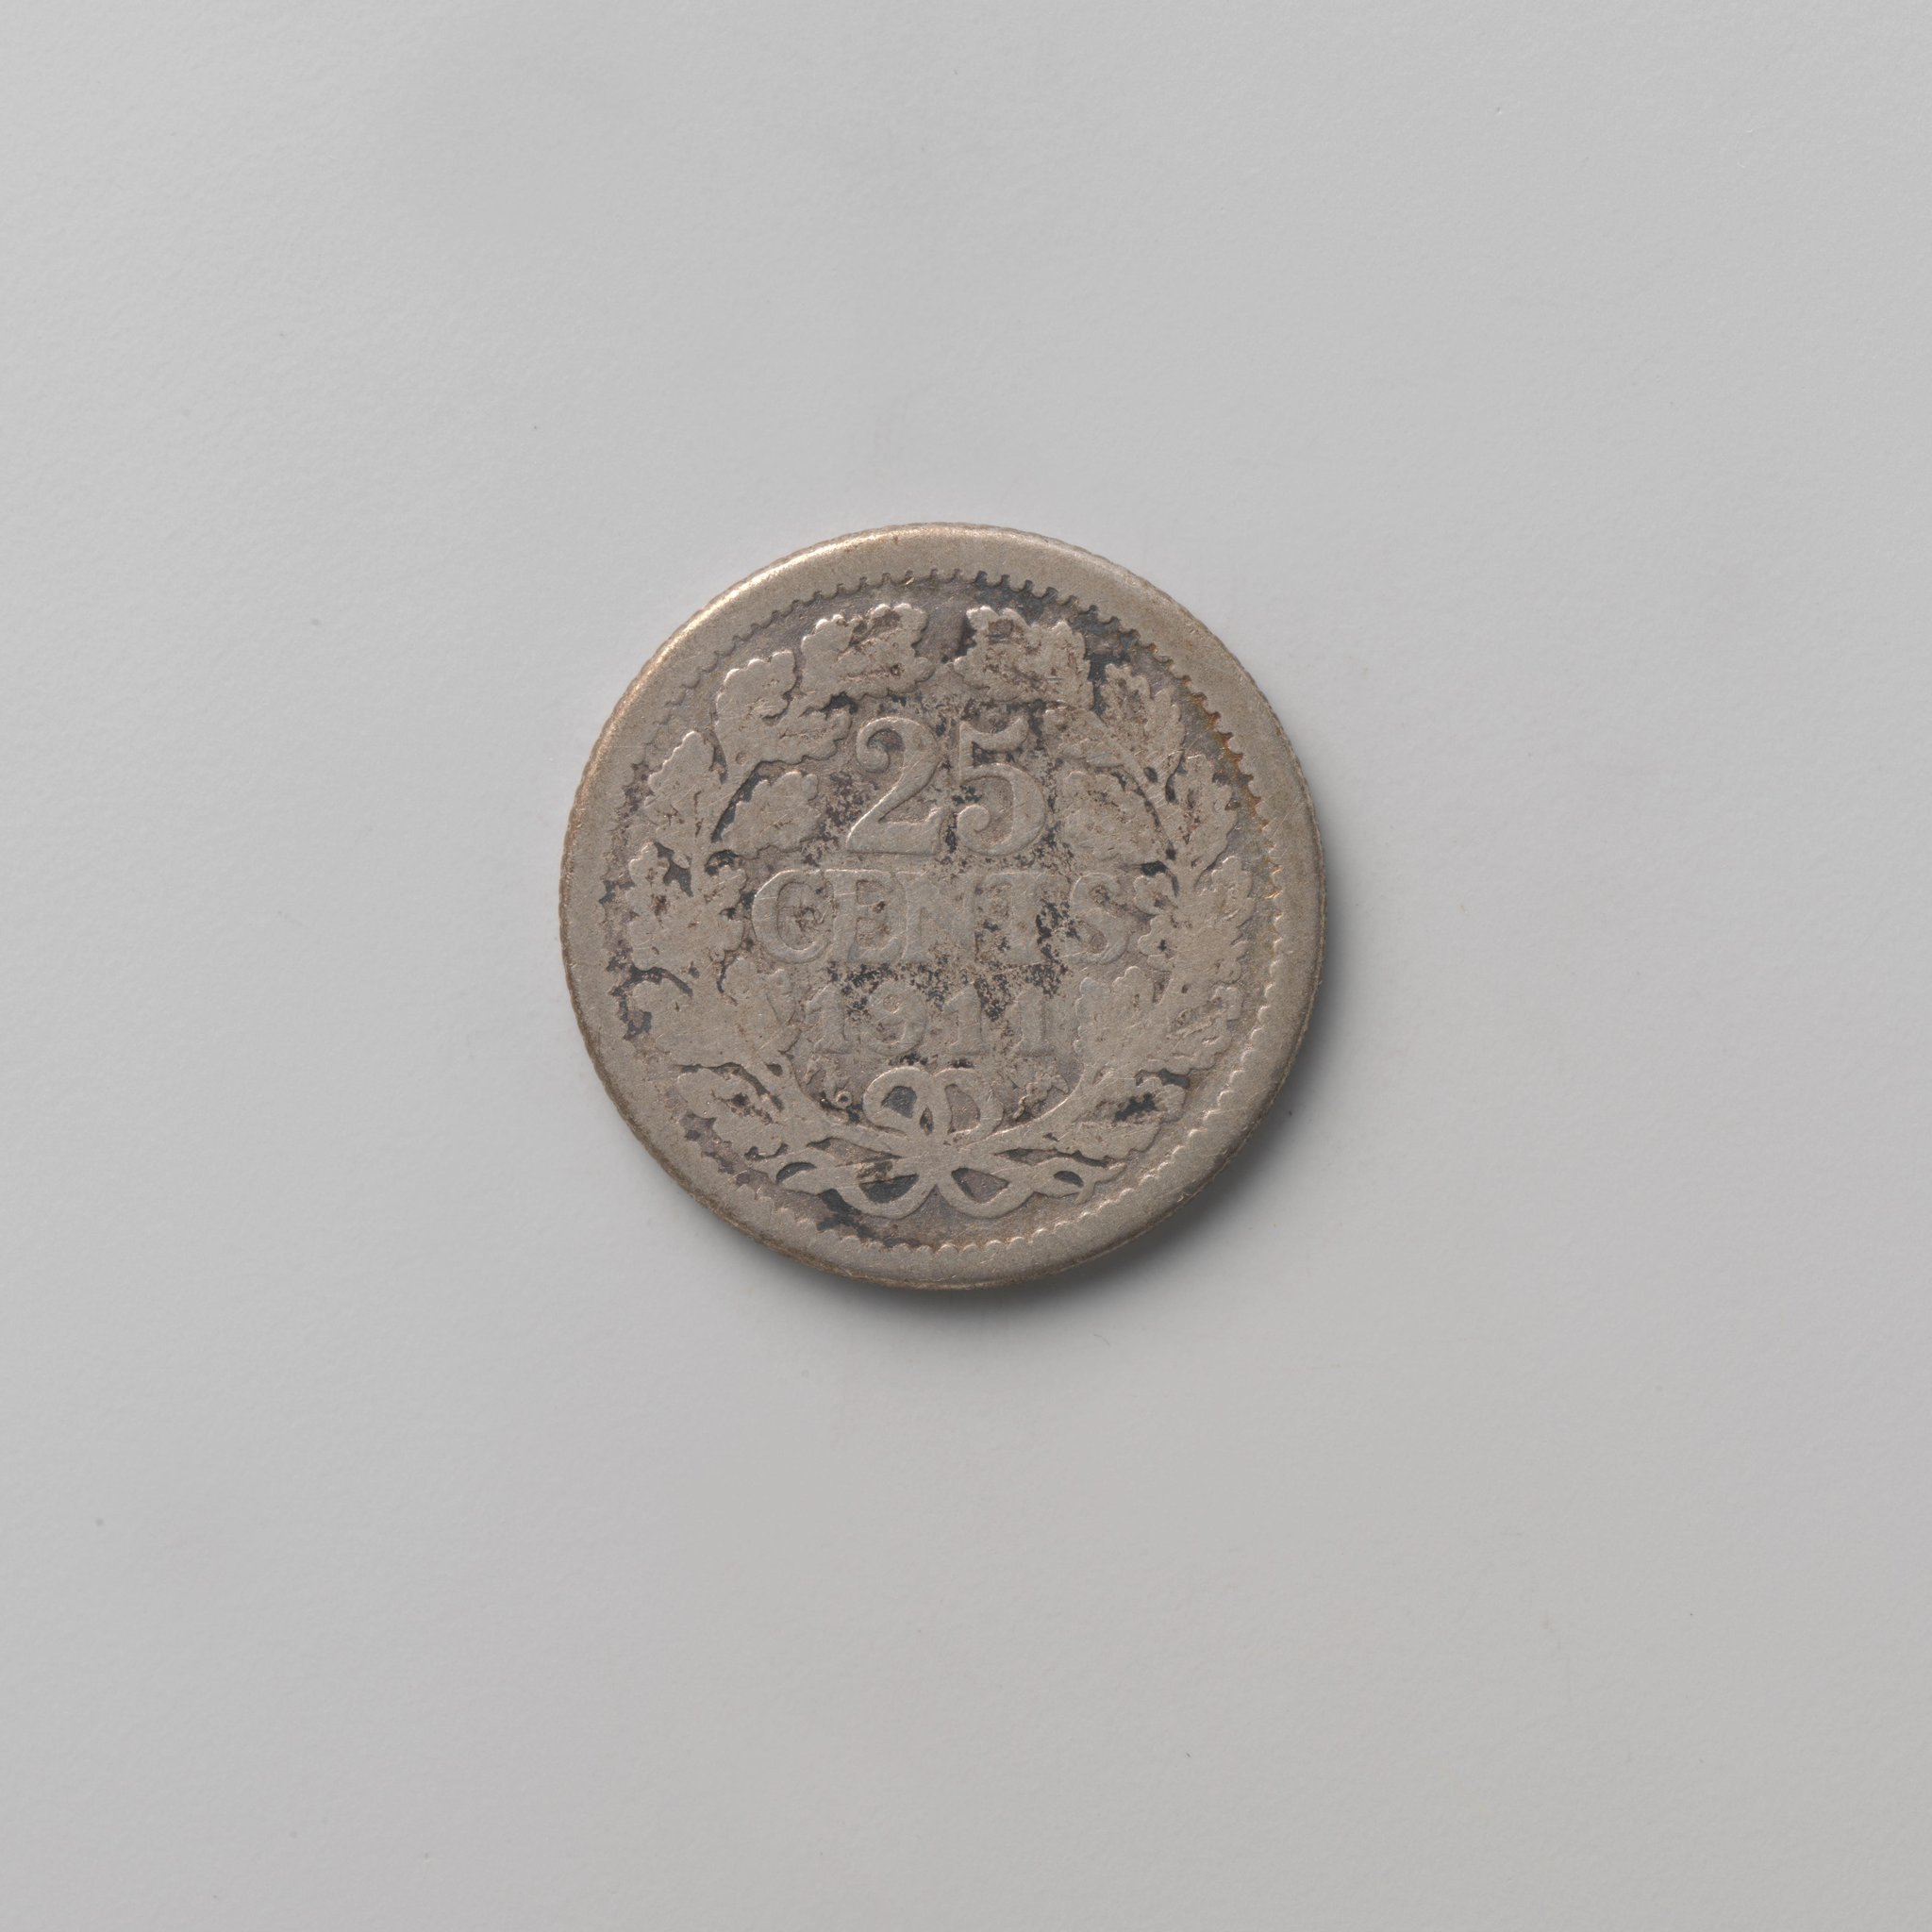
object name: coin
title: Nederlandse 25 cent,1911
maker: wilhelmina of the netherlands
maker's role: print maker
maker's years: 1880-1962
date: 1911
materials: silver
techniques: striking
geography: utrecht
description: Zilveren munt. Voorzijde: gedrapeerd borstbeeld naar links. Keerzijde: binnen twee samengebonden eiketakken waarde-aanduiding 25 cents en jaartal. Kartelrand.